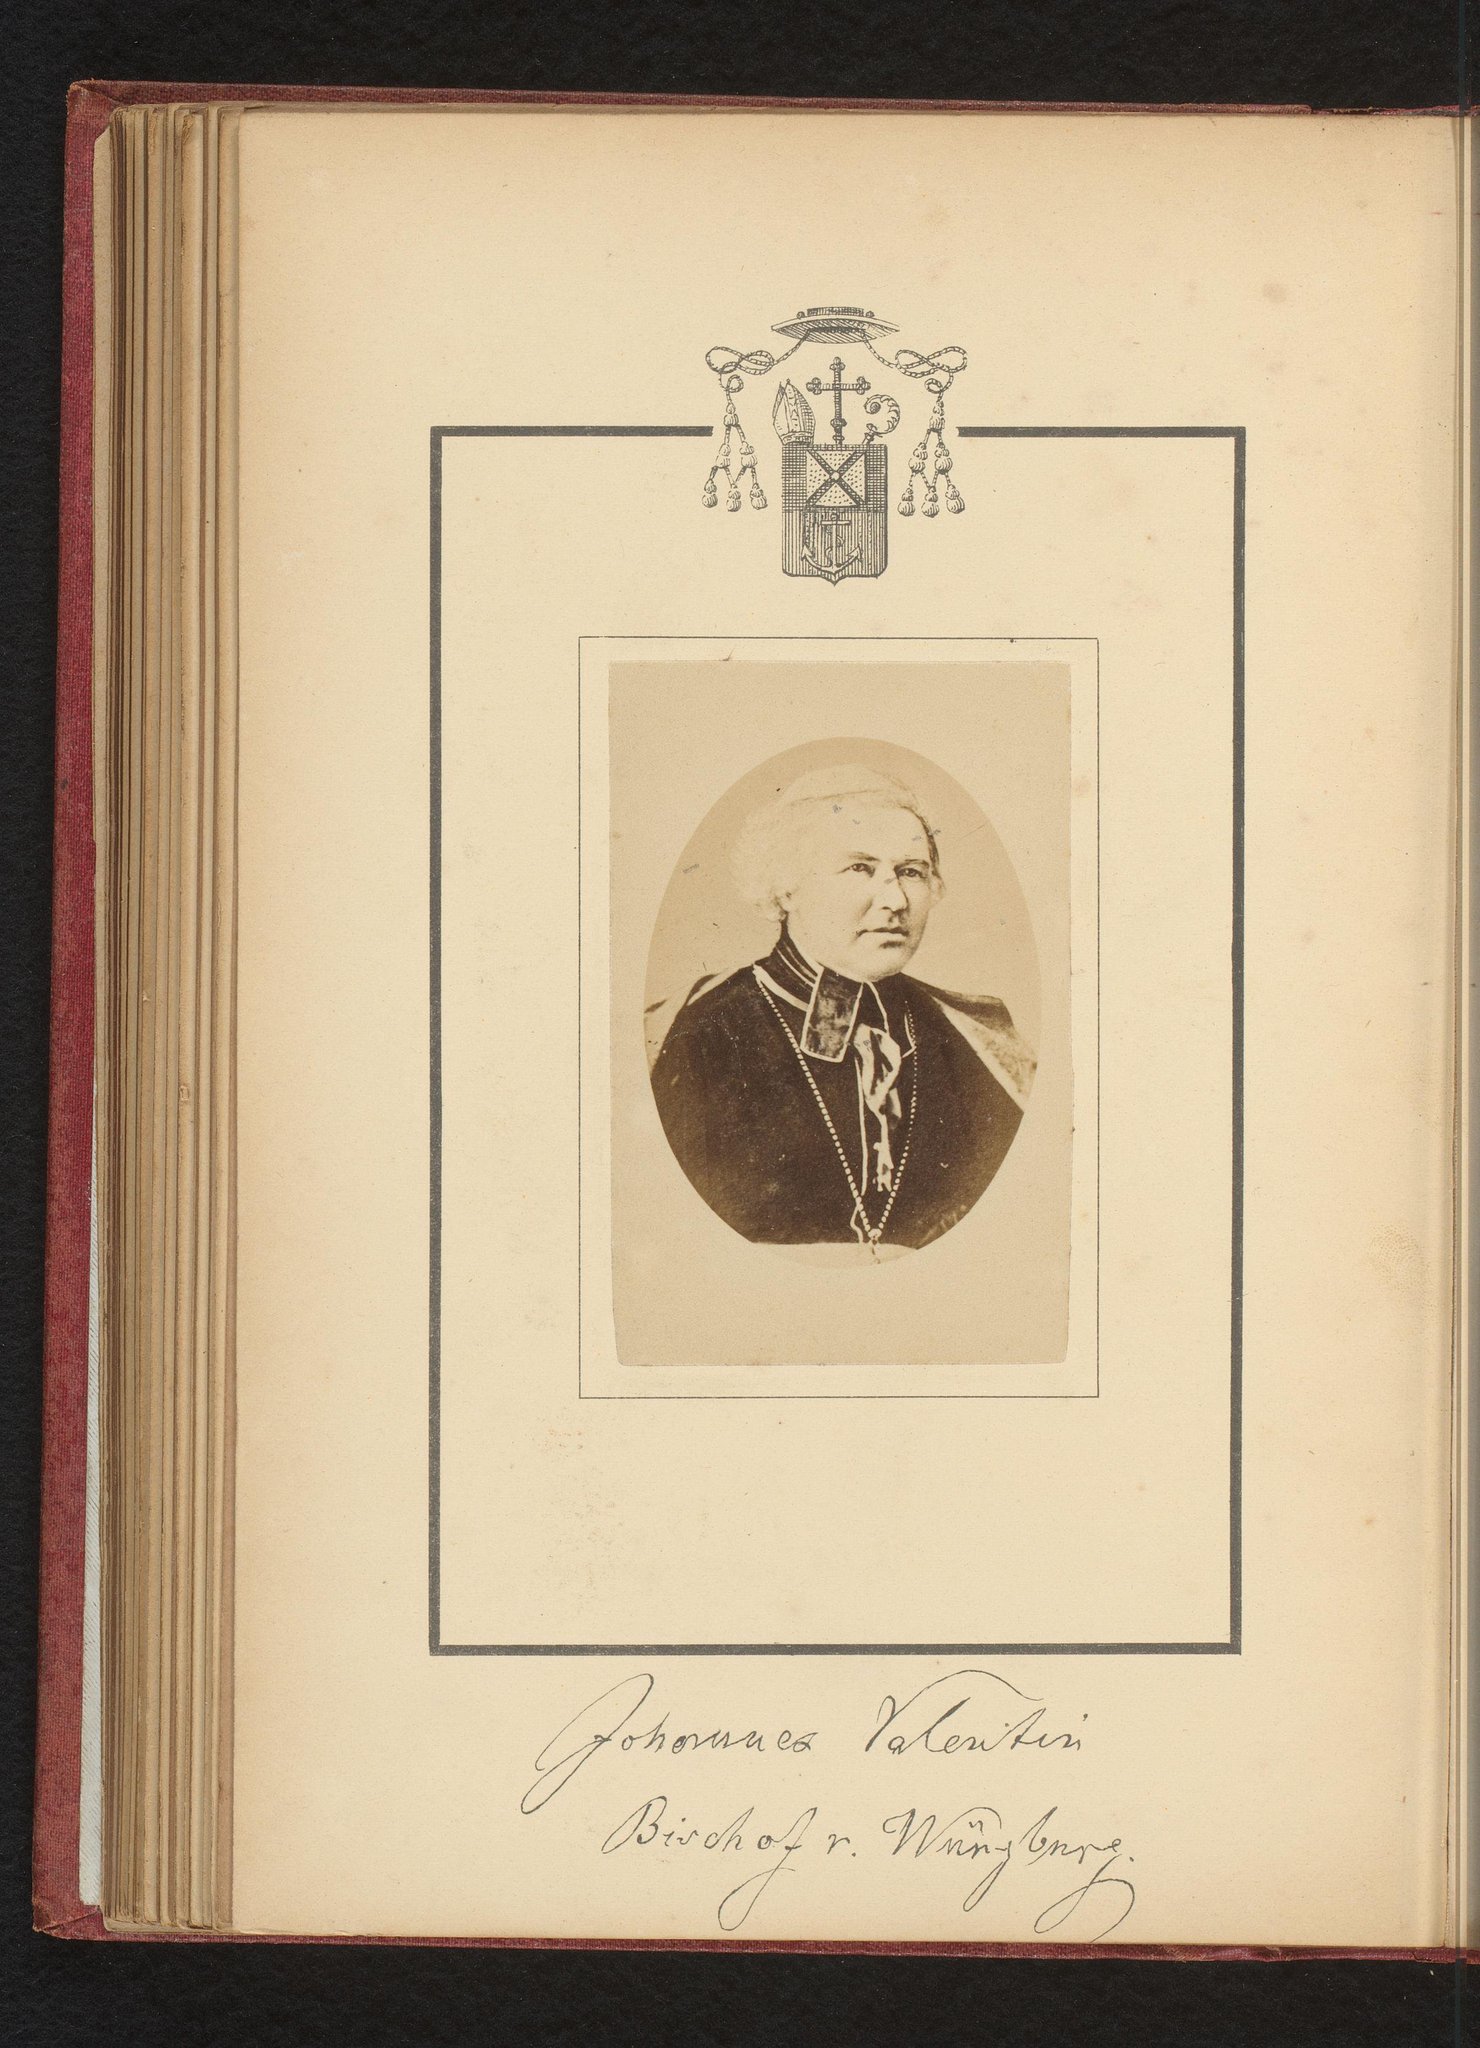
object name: page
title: Portret van bisschop Johann Valentin von Reißmann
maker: Anonymous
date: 1863-1873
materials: photographic support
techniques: albumen print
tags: archbishop, bishop, etc. (roman catholic)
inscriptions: inscription: ‘Johannes Valentin Bischof v. Würsburg.’